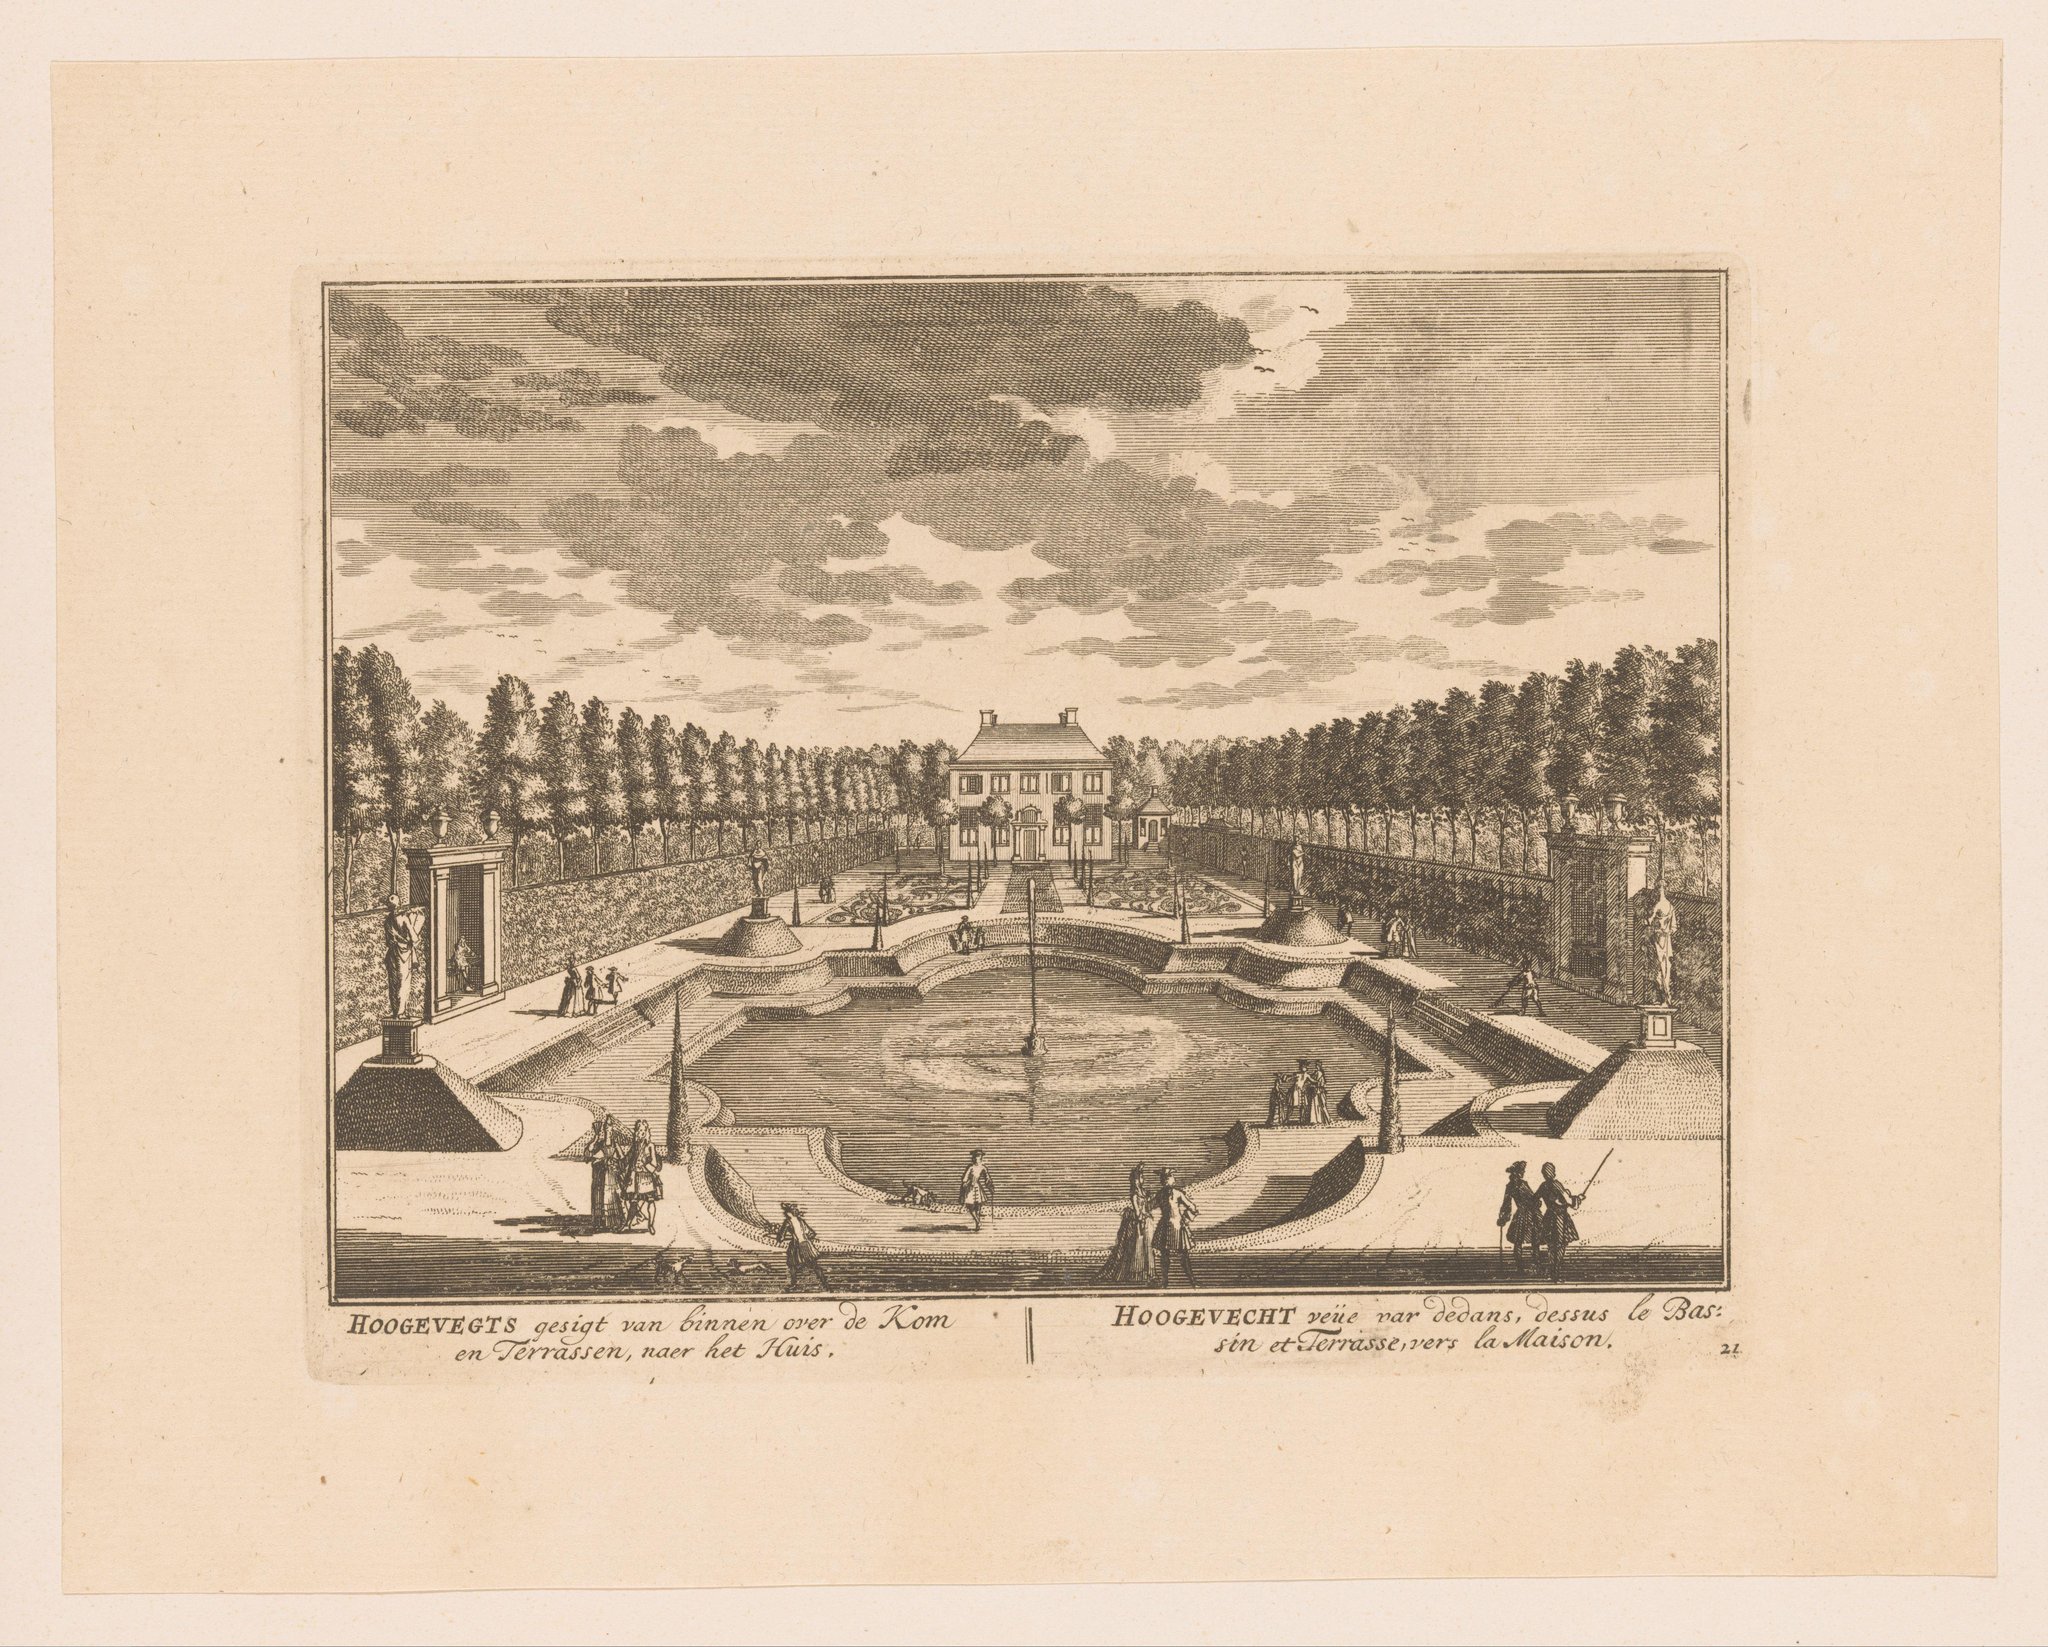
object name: print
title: Hoogevegts gesigt van binnen over de Kom en Terrassen, naer het Huis / Hoogevecht veüe par dedans, dessus le Bassin et Terrasse, vers la Maison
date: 1719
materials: paper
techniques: etching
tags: rural housing, e.g. country-house, villa, cottage, french or architectonic garden; formal garden, garden pond, maarssen, vecht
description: Prent uit: De zegepraalende Vecht, vertoonende verscheidene gesichten van lustplaatsen, heeren huysen en dorpen, beginnende van Uitrecht en met Muyden besluytende. Amsterdam: Wed. Nicolaes Visscher, 1719.